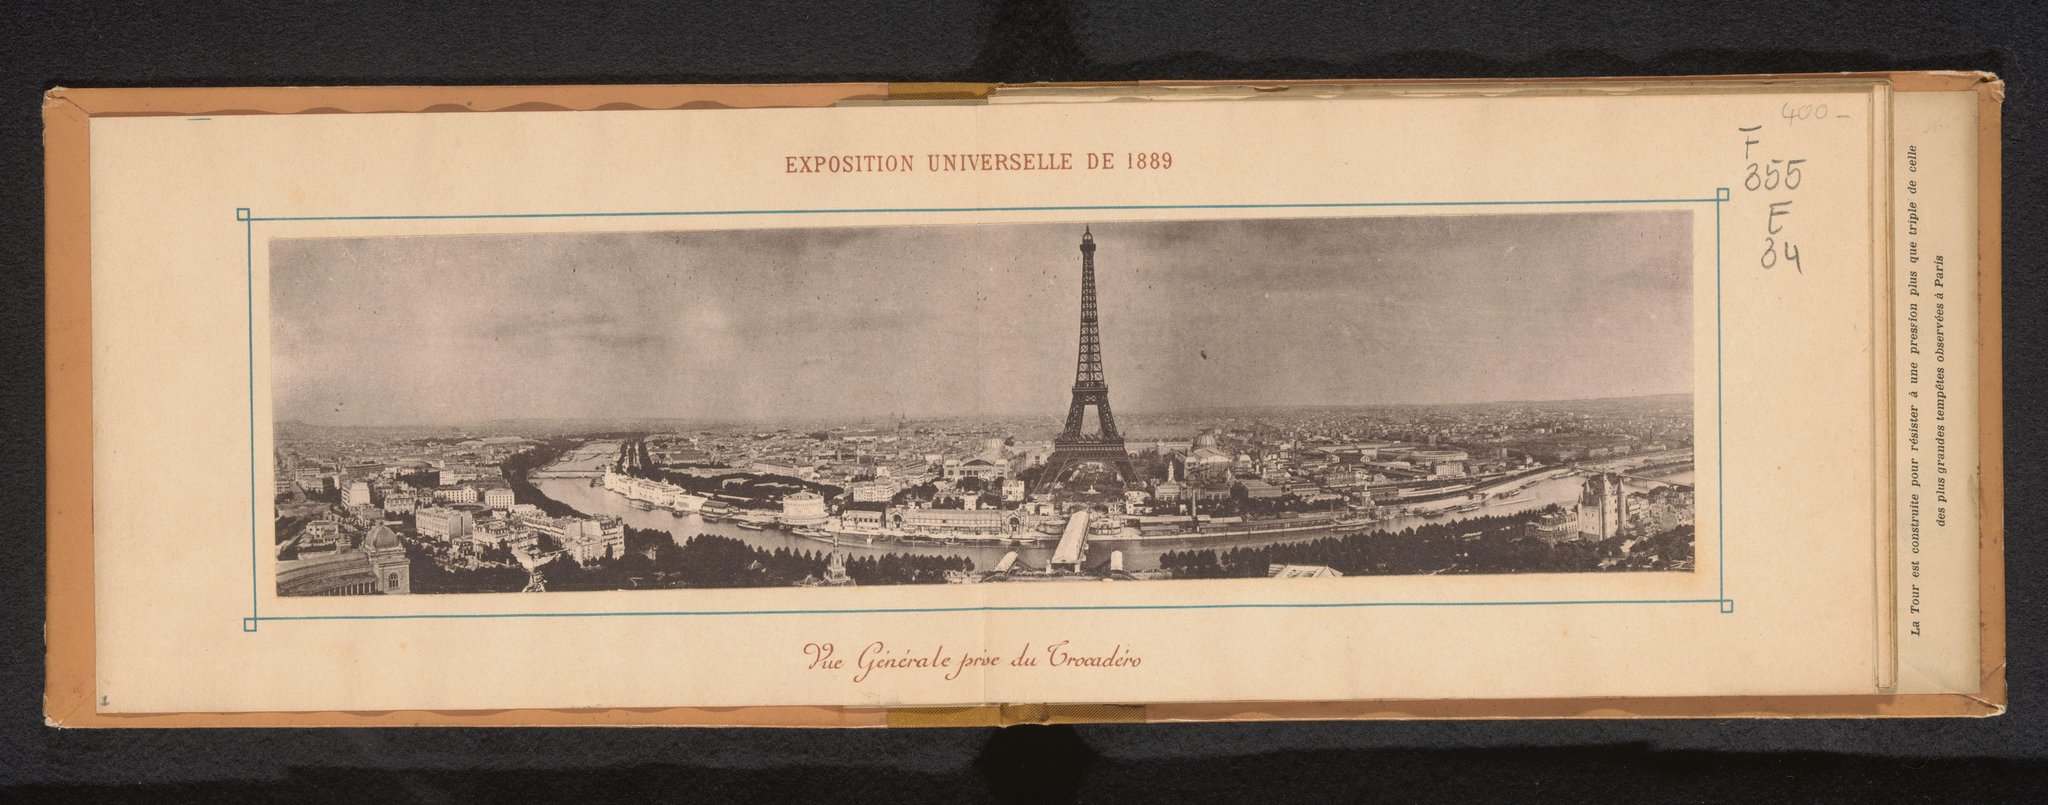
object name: page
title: Vue Générale prise du Trocadéro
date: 1889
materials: paper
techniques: photograph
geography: paris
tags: city-view, and landscape with man-made constructions, eiffel tower